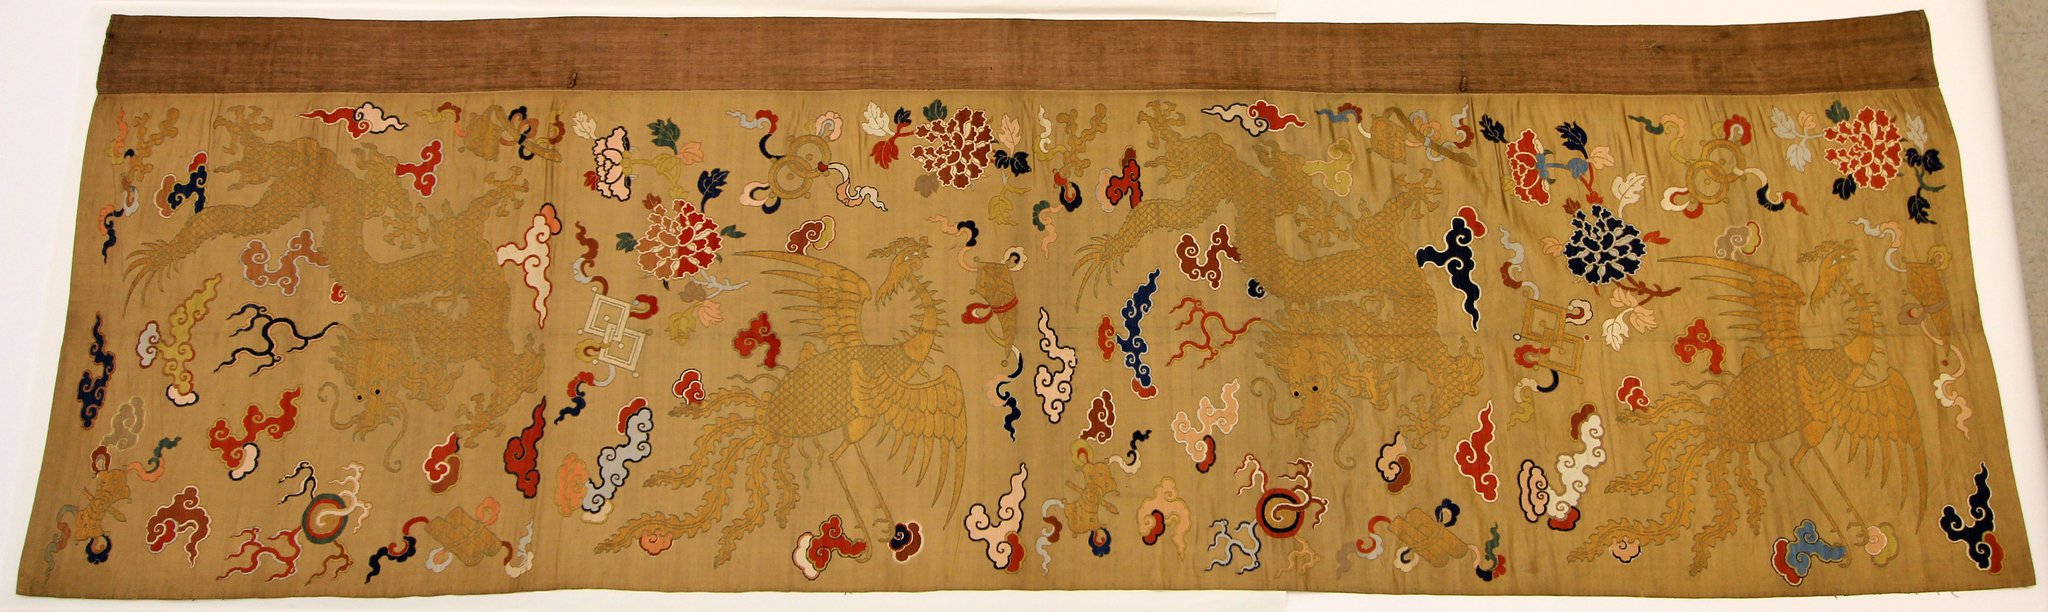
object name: panel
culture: chinese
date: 1701-1900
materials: gold, silk, thread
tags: dragons